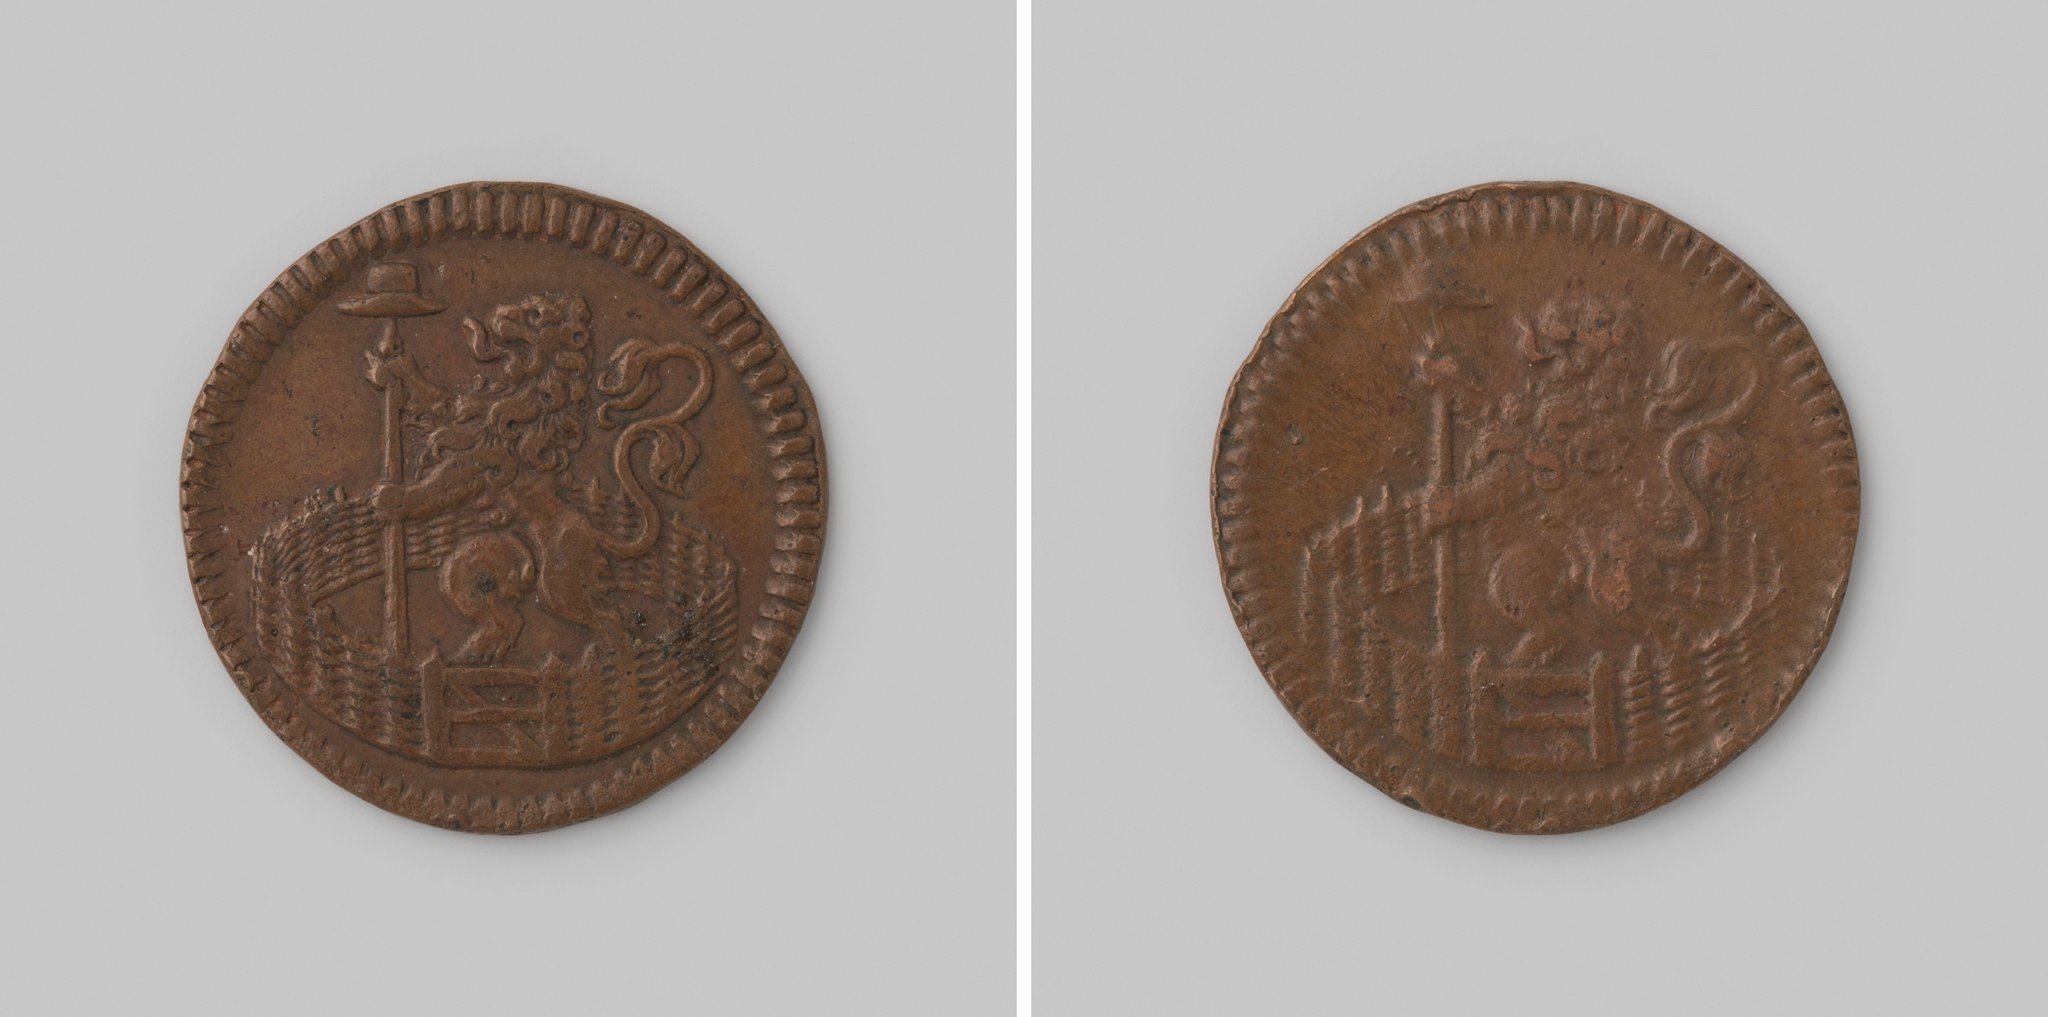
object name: coin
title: Holland, duit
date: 1702-1780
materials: copper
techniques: striking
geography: dordrecht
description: Koperen munt. Voorzijde: binnen omheining staande leeuw met vrijheidshoed op speer. Keerzijde: binnen omheining staande leeuw met vrijheidshoed op speer.